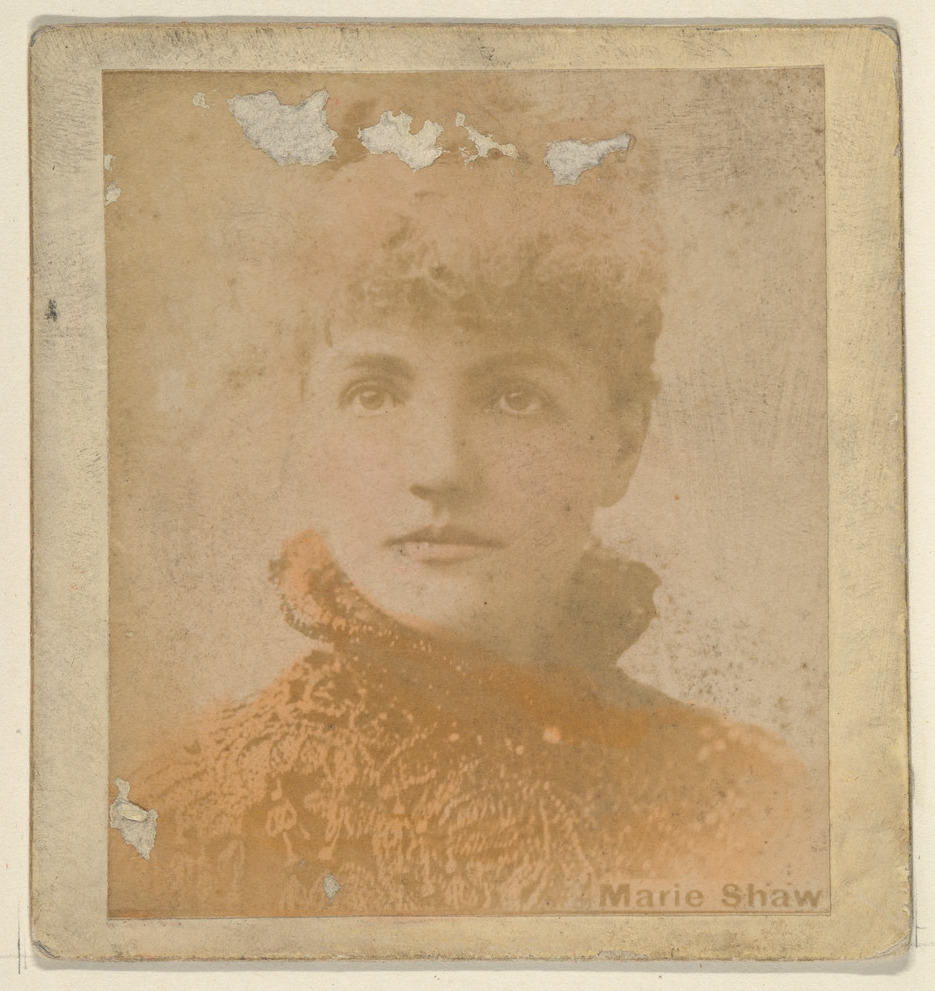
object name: photograph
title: Marie Shaw, from the Actresses series (N246), Type 2, issued by Kinney Brothers to promote Sporting Extra Cigarettes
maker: kinney brothers tobacco company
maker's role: publisher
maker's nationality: american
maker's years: 1869-2011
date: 1890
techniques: albumen silver print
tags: portraits,women,actresses